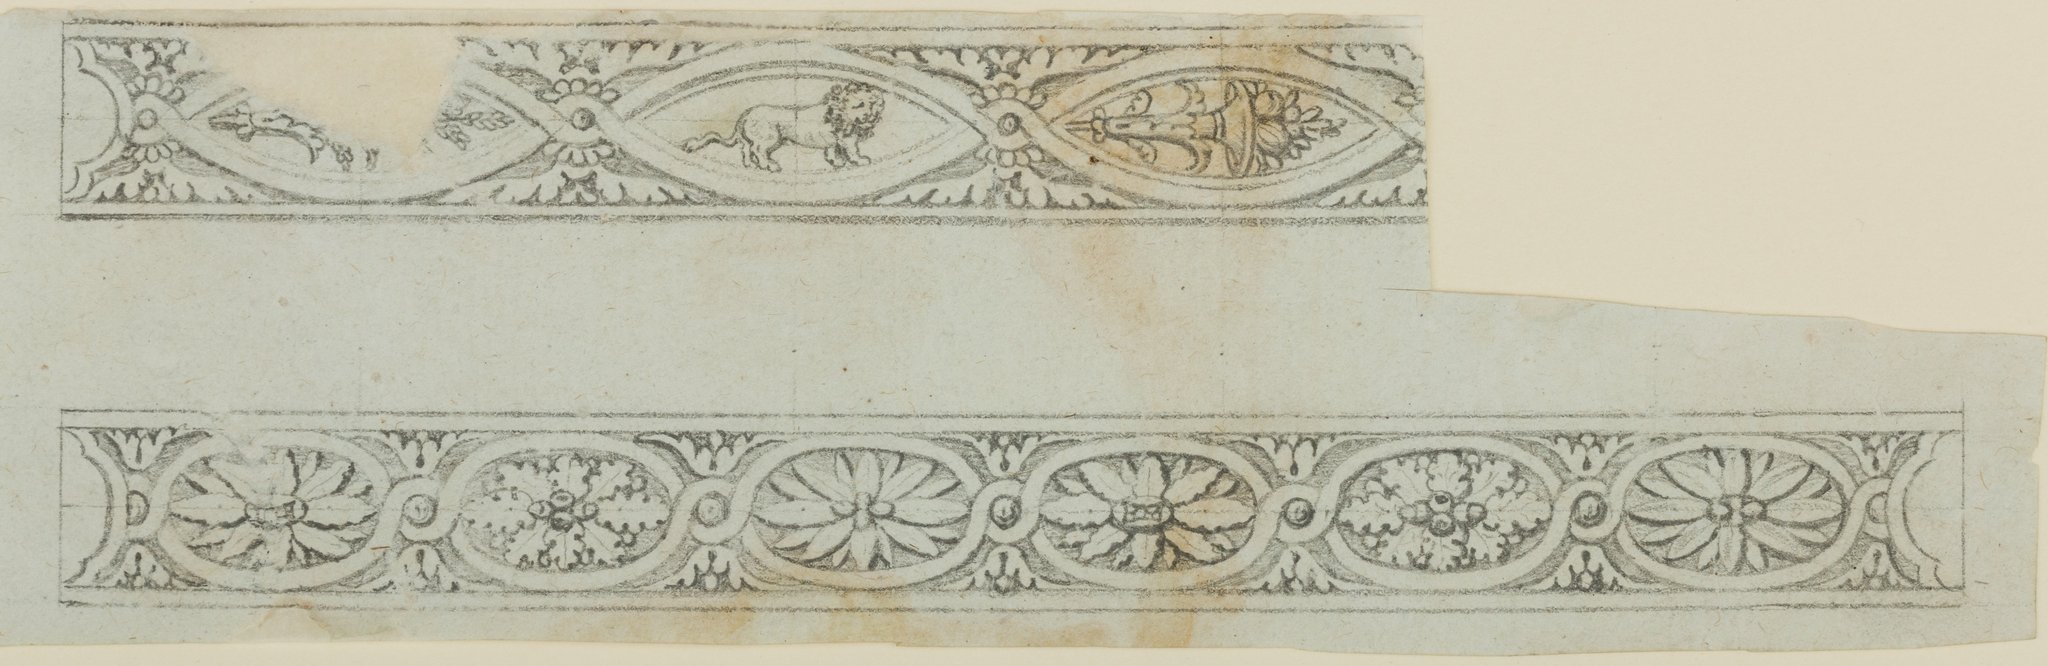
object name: drawing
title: Designs for the Decoration of Firearms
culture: french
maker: nicolas noël boutet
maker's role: designer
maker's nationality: french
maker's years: 1761-1833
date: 1797-1805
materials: ink, paper, pencil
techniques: wash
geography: france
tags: ornament,lions